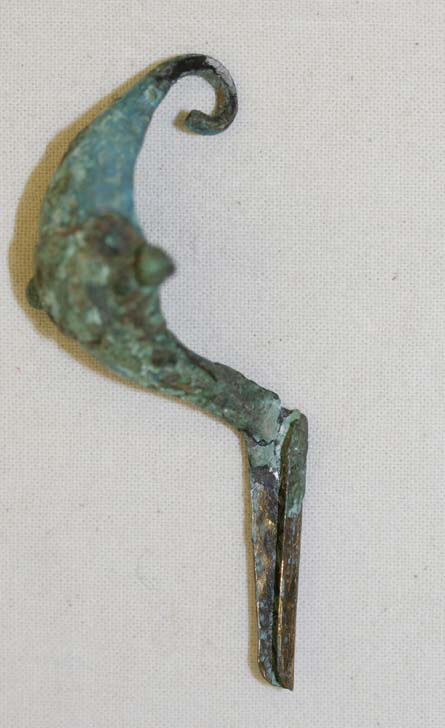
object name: pin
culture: european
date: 400-301 BCE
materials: bronze